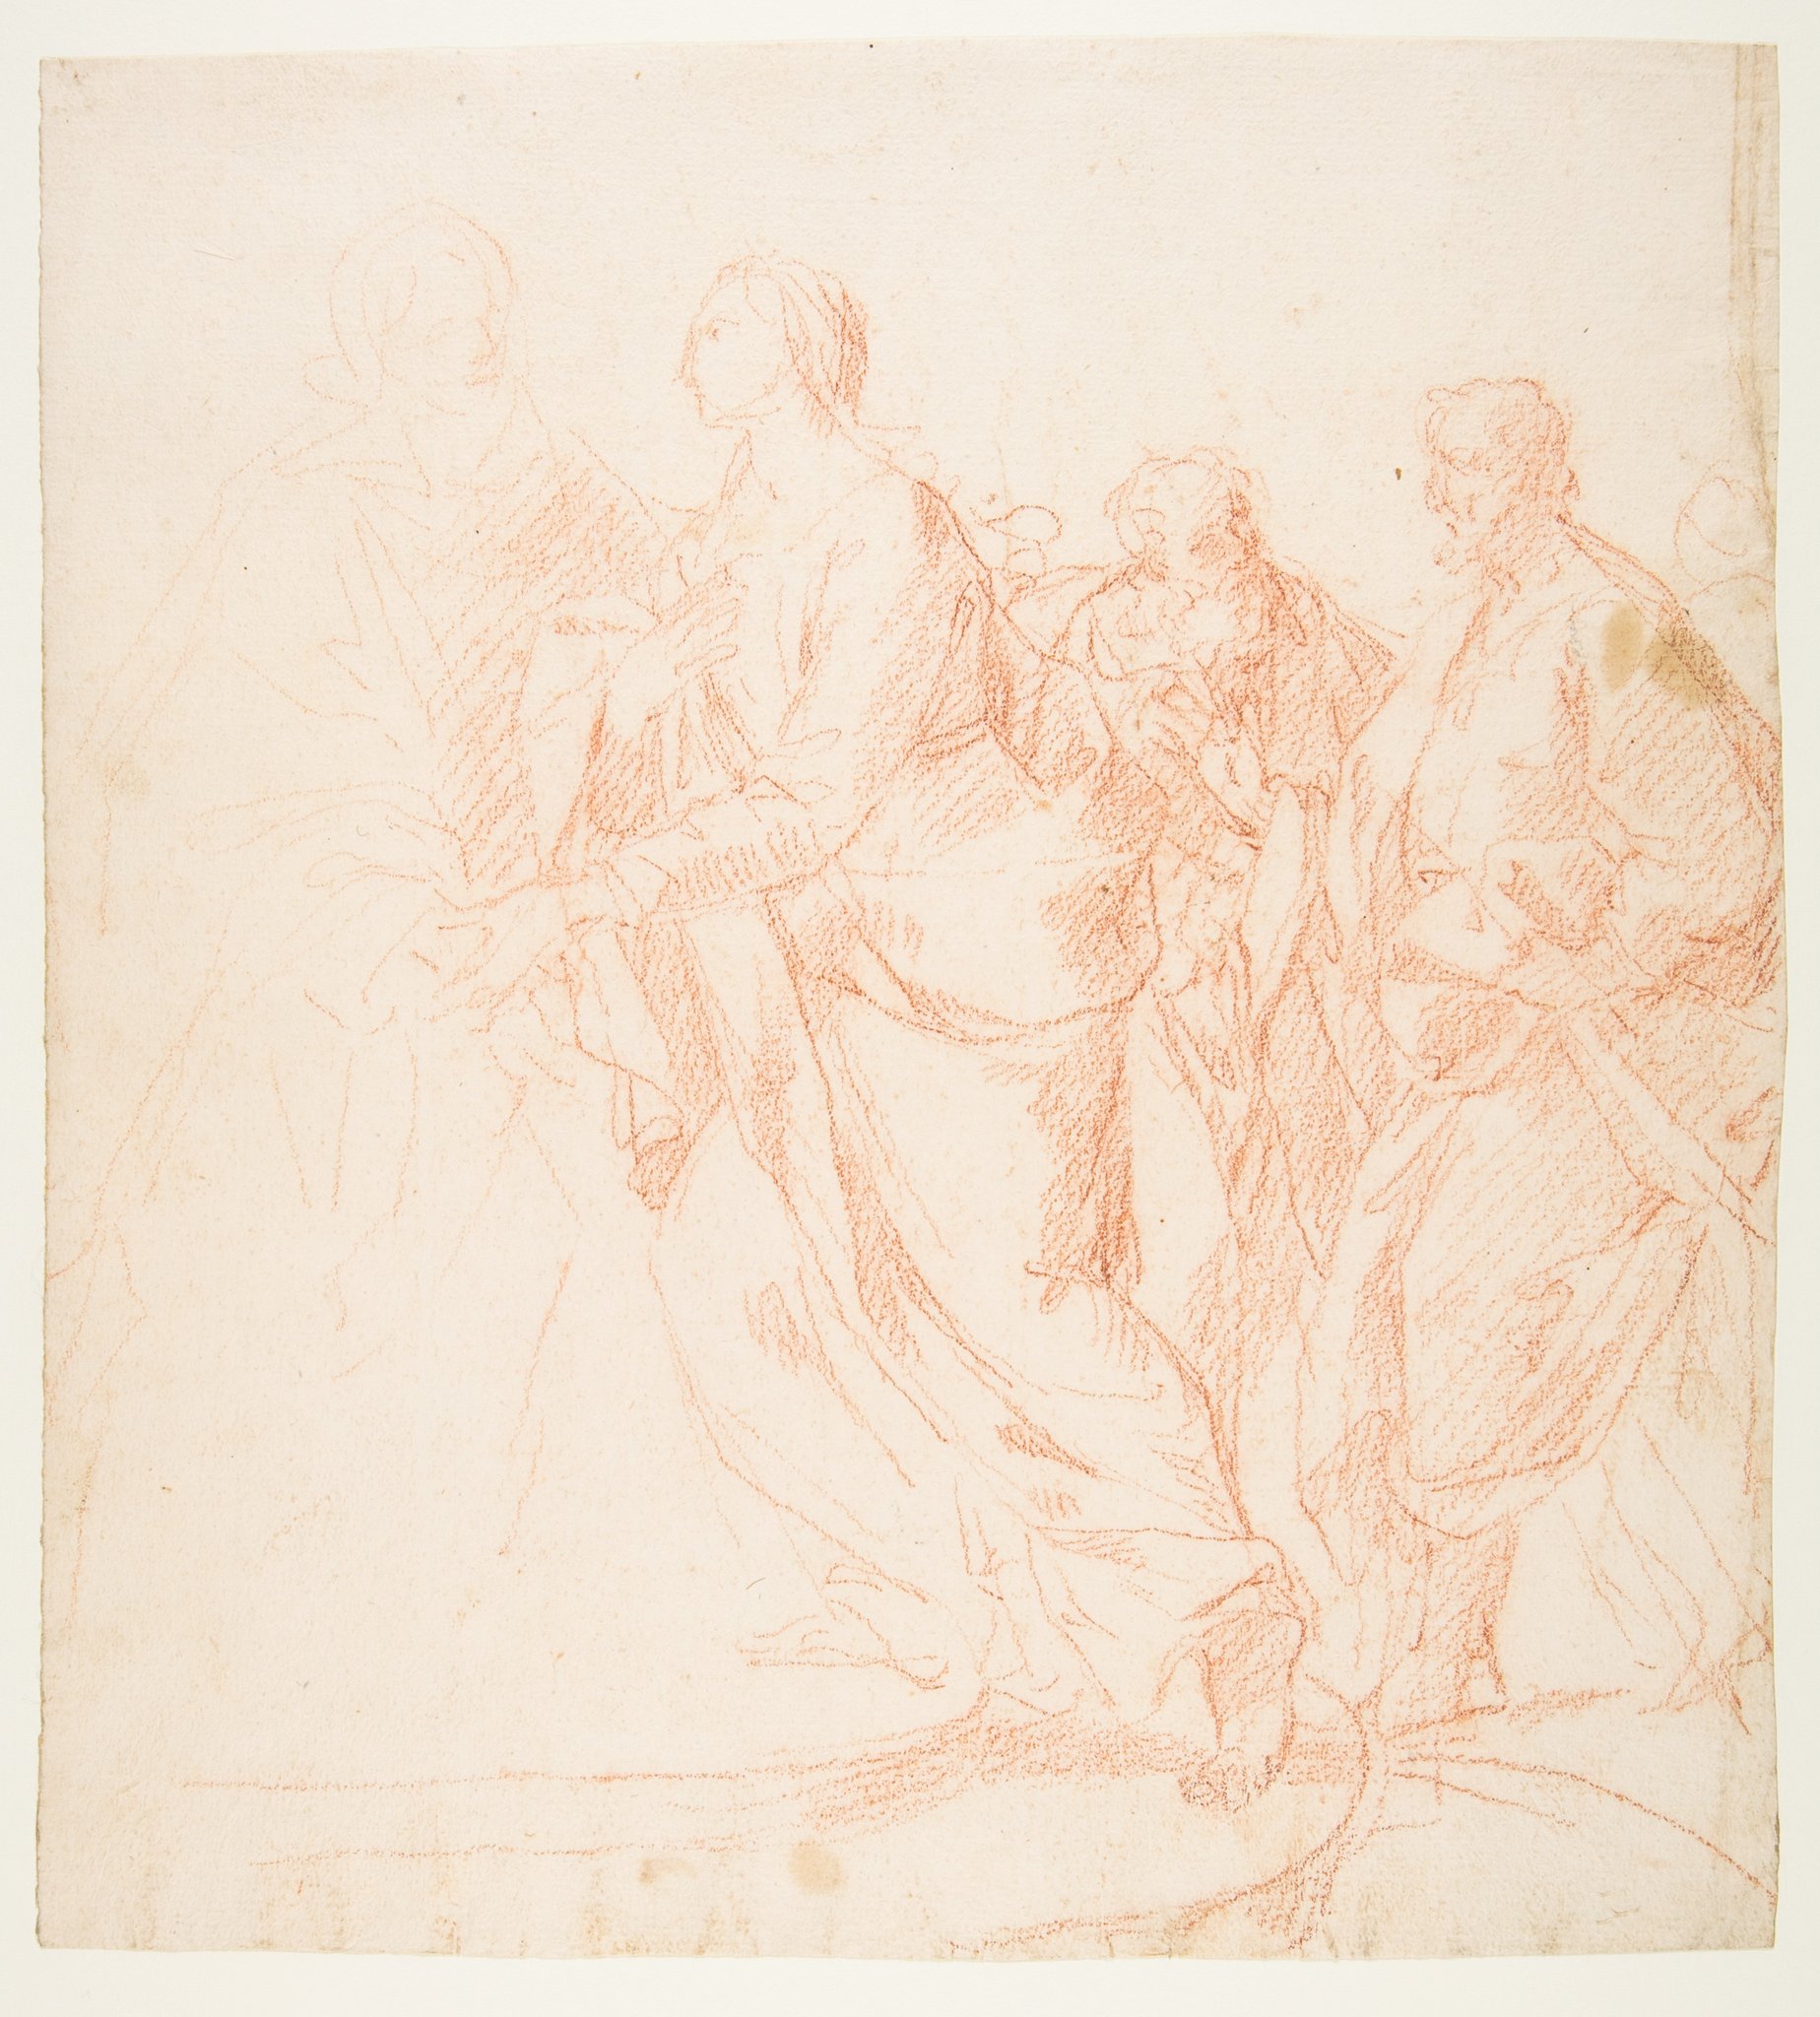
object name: drawing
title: The Visitation of Our Lady (Luke 1:39-56)(recto); Zachariah (verso)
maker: giacomo zoboli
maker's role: artist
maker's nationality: italian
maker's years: 1681-1767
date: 1681-1767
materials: chalk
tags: men,women